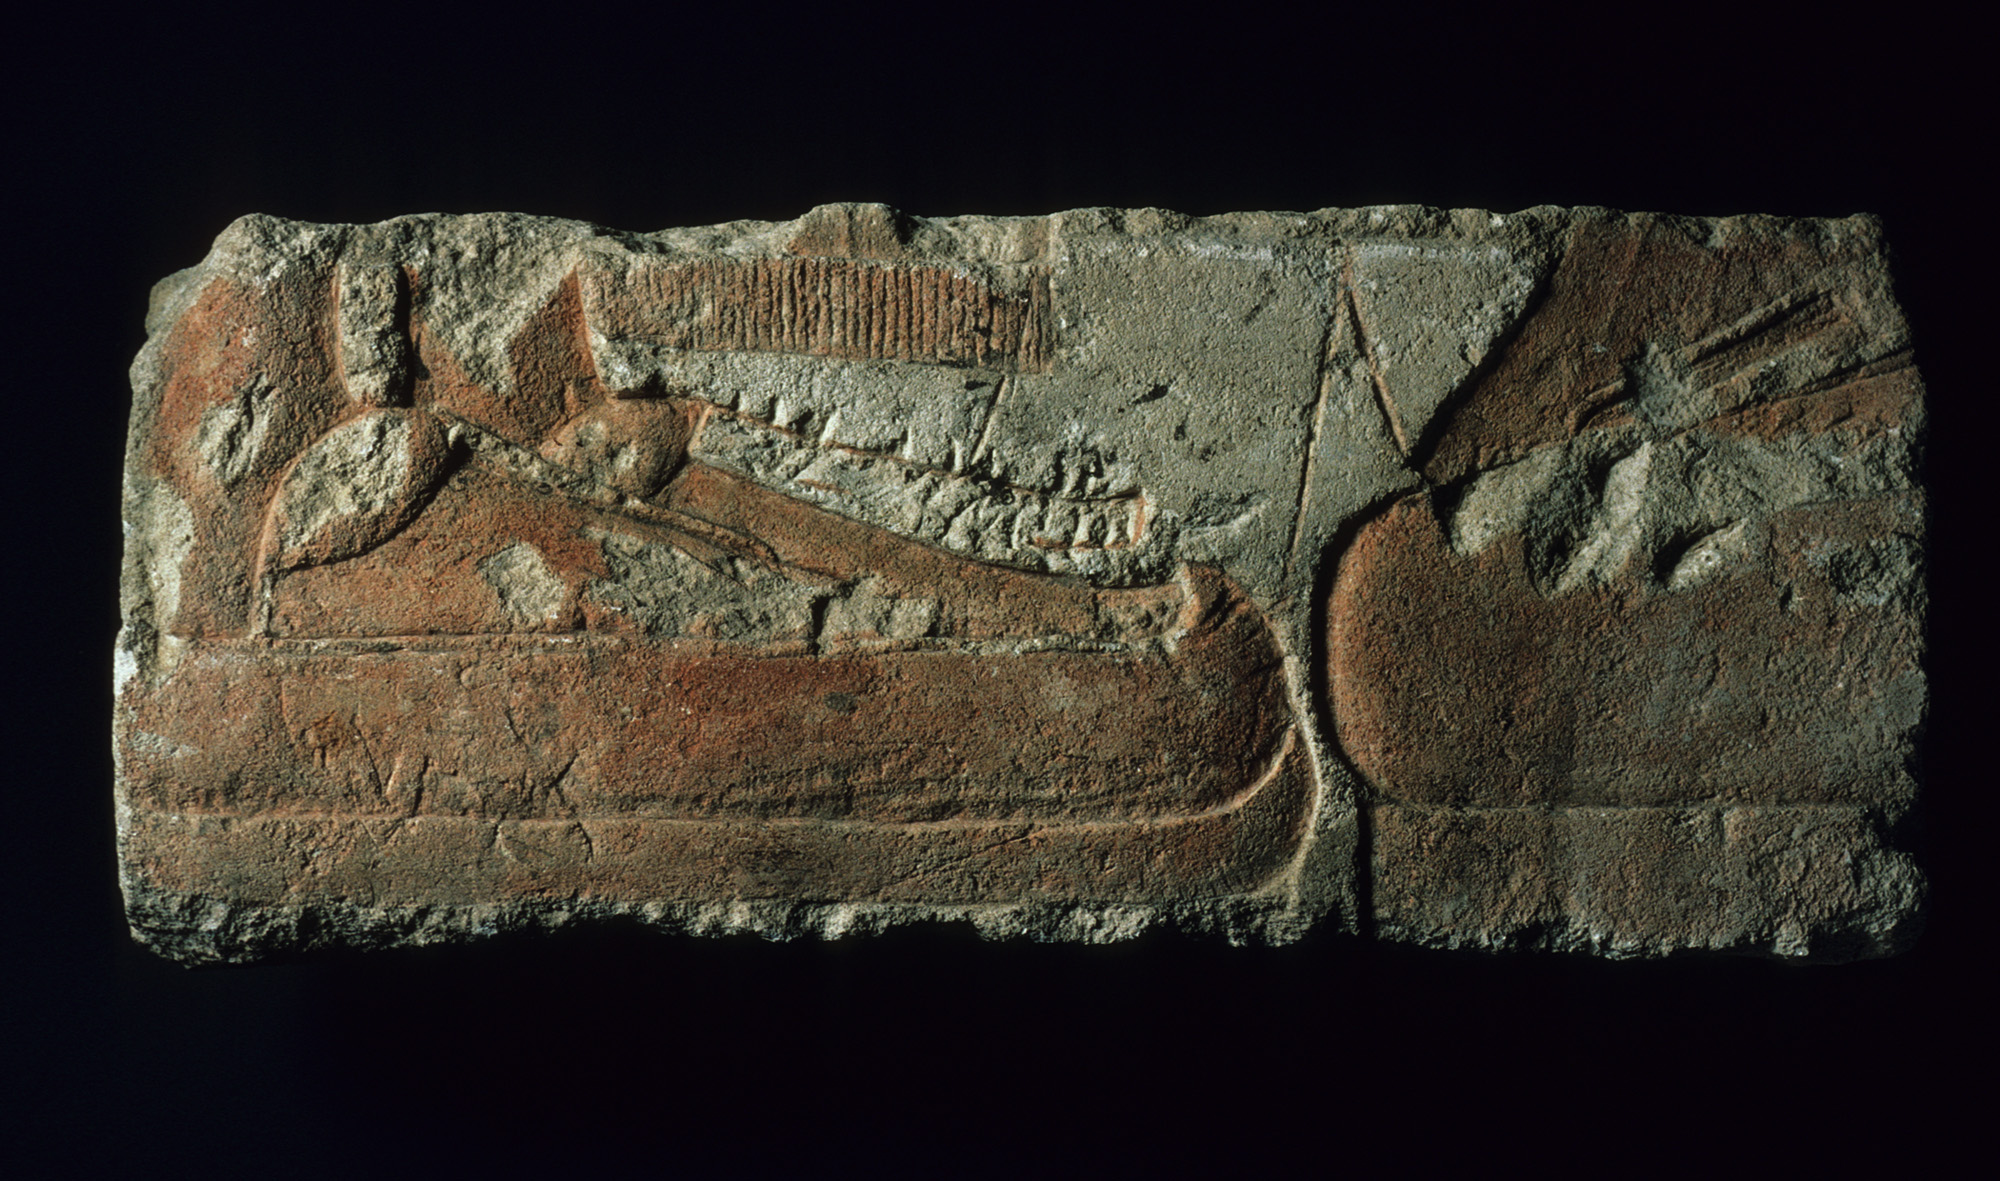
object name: talatat, royal foot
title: Fragment with royal feet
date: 1353-1336 BCE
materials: limestone, paint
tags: feet